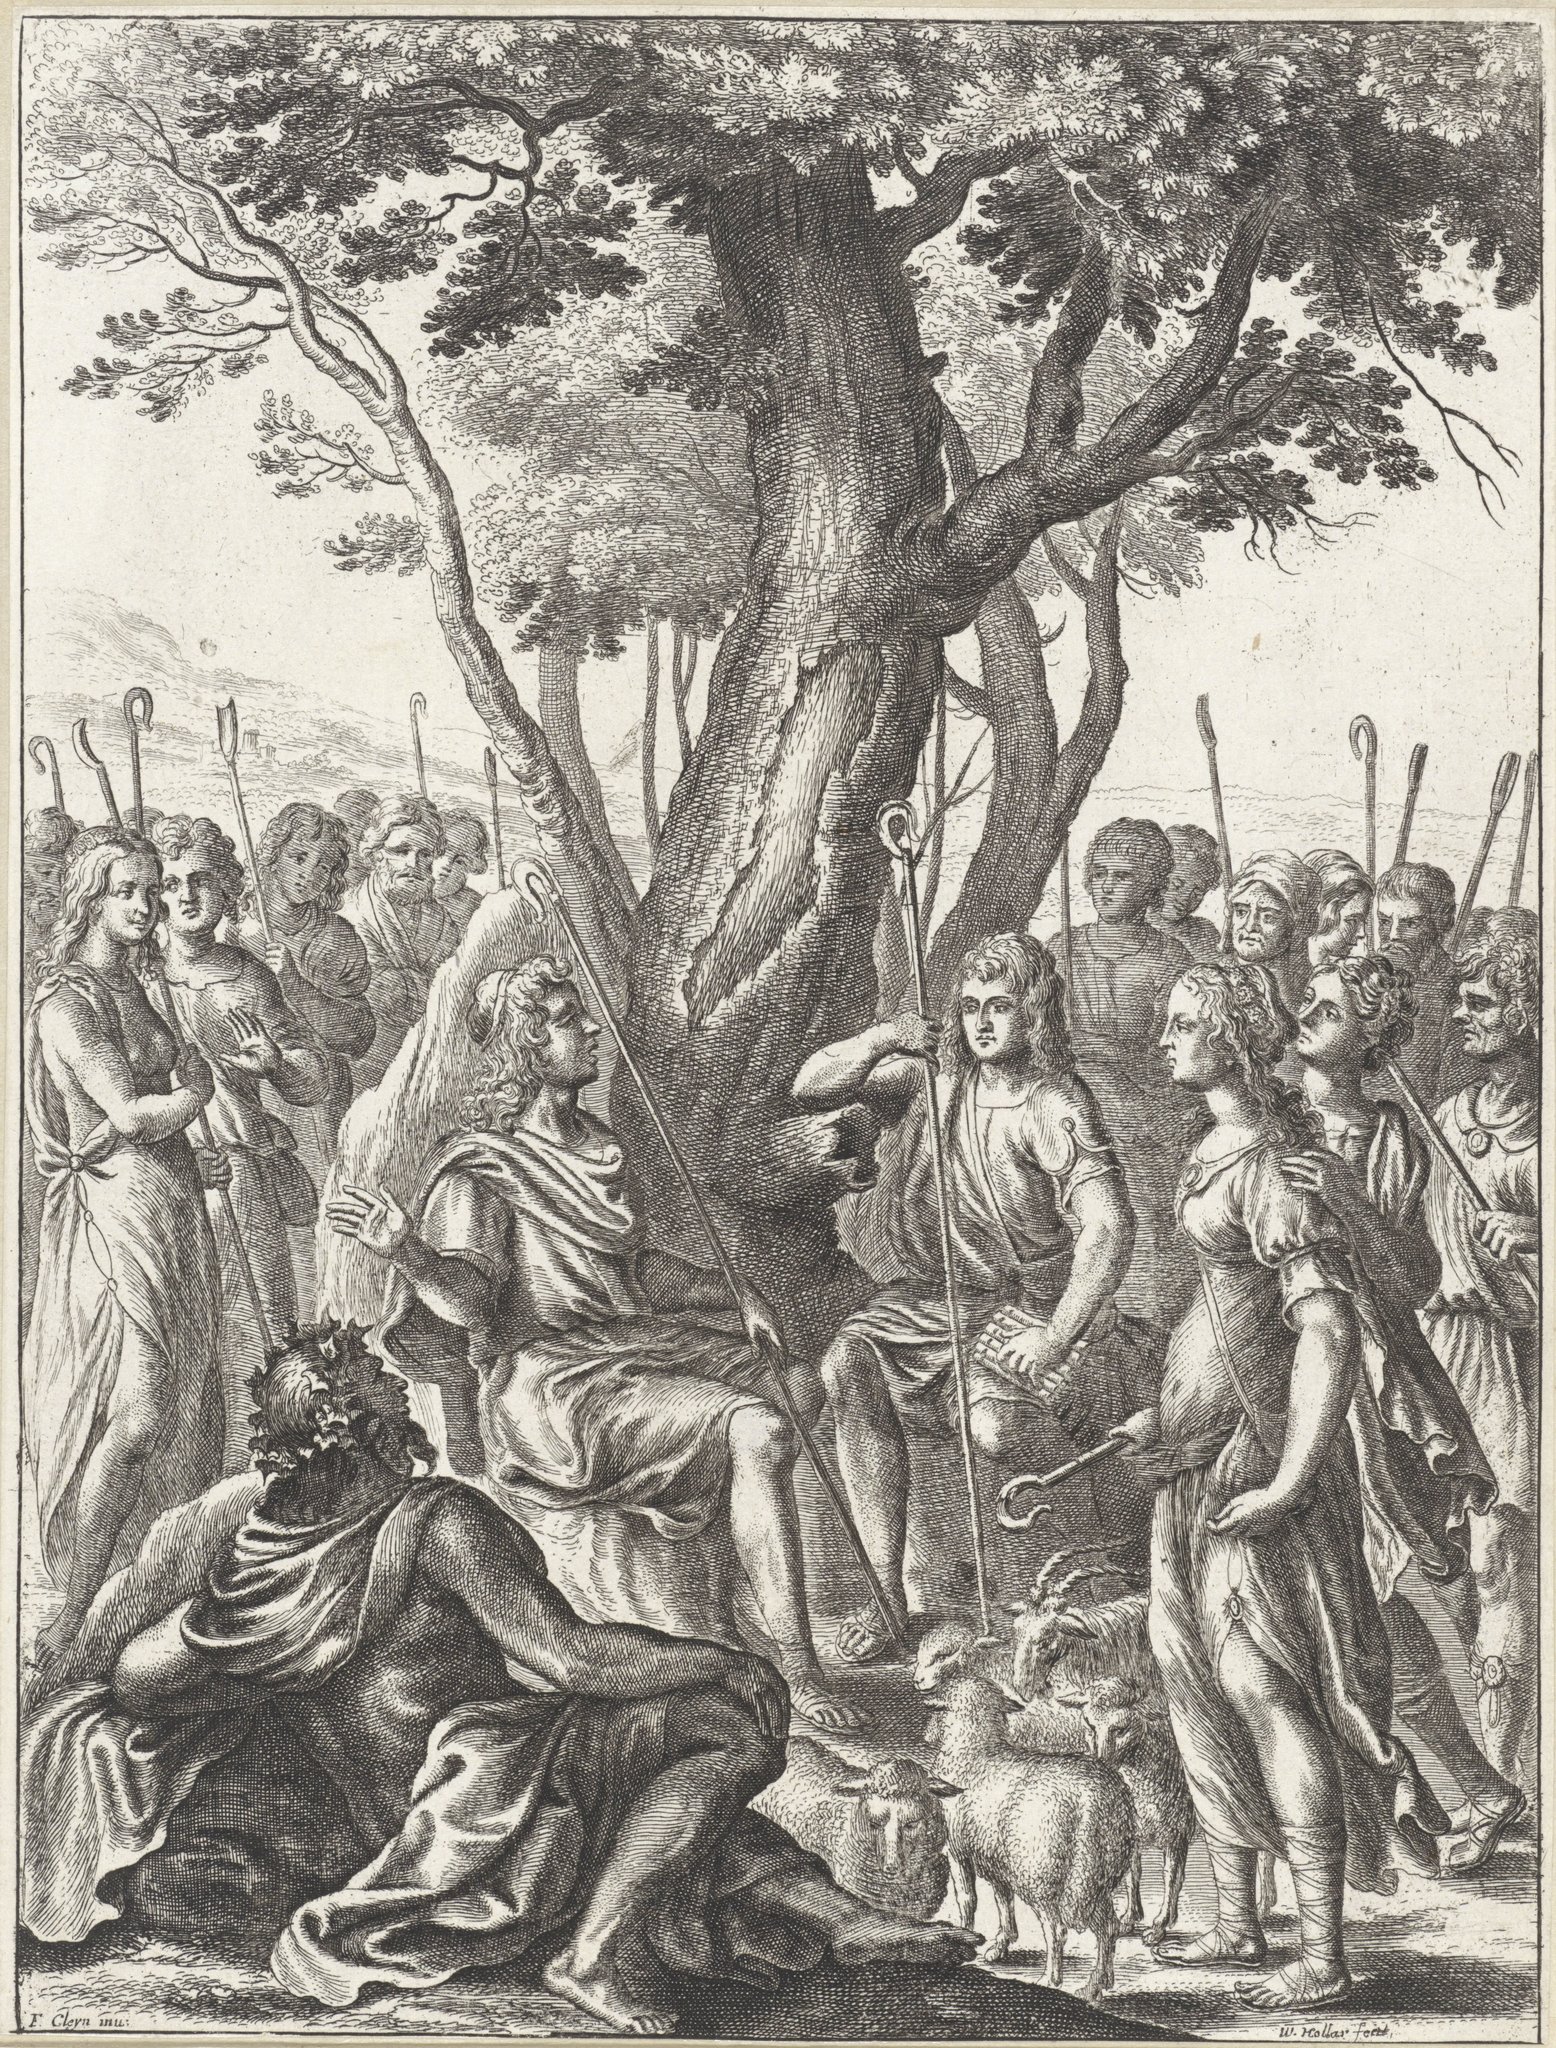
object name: book illustration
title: Werken van Vergilius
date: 1654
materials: paper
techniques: etching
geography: london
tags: herding, herdsman, herdswoman, shepherd, shepherdess, cowherd, etc.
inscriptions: collector's mark: Lugt 2228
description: Prent opgenomen in: Vergilius Maro, Publius. The works of Publius Virgilius Maro. Translated, adorned with sculpture, and illustrated with annotations, by John Ogilby. Londen: Thomas Warren, 1654. Prent tevens opgenomen in latere, in Engeland verschenen, uitgaven van Vergilius´ werken in 1658, 1663, 1668, 1697 en 1698 (zie NHG).